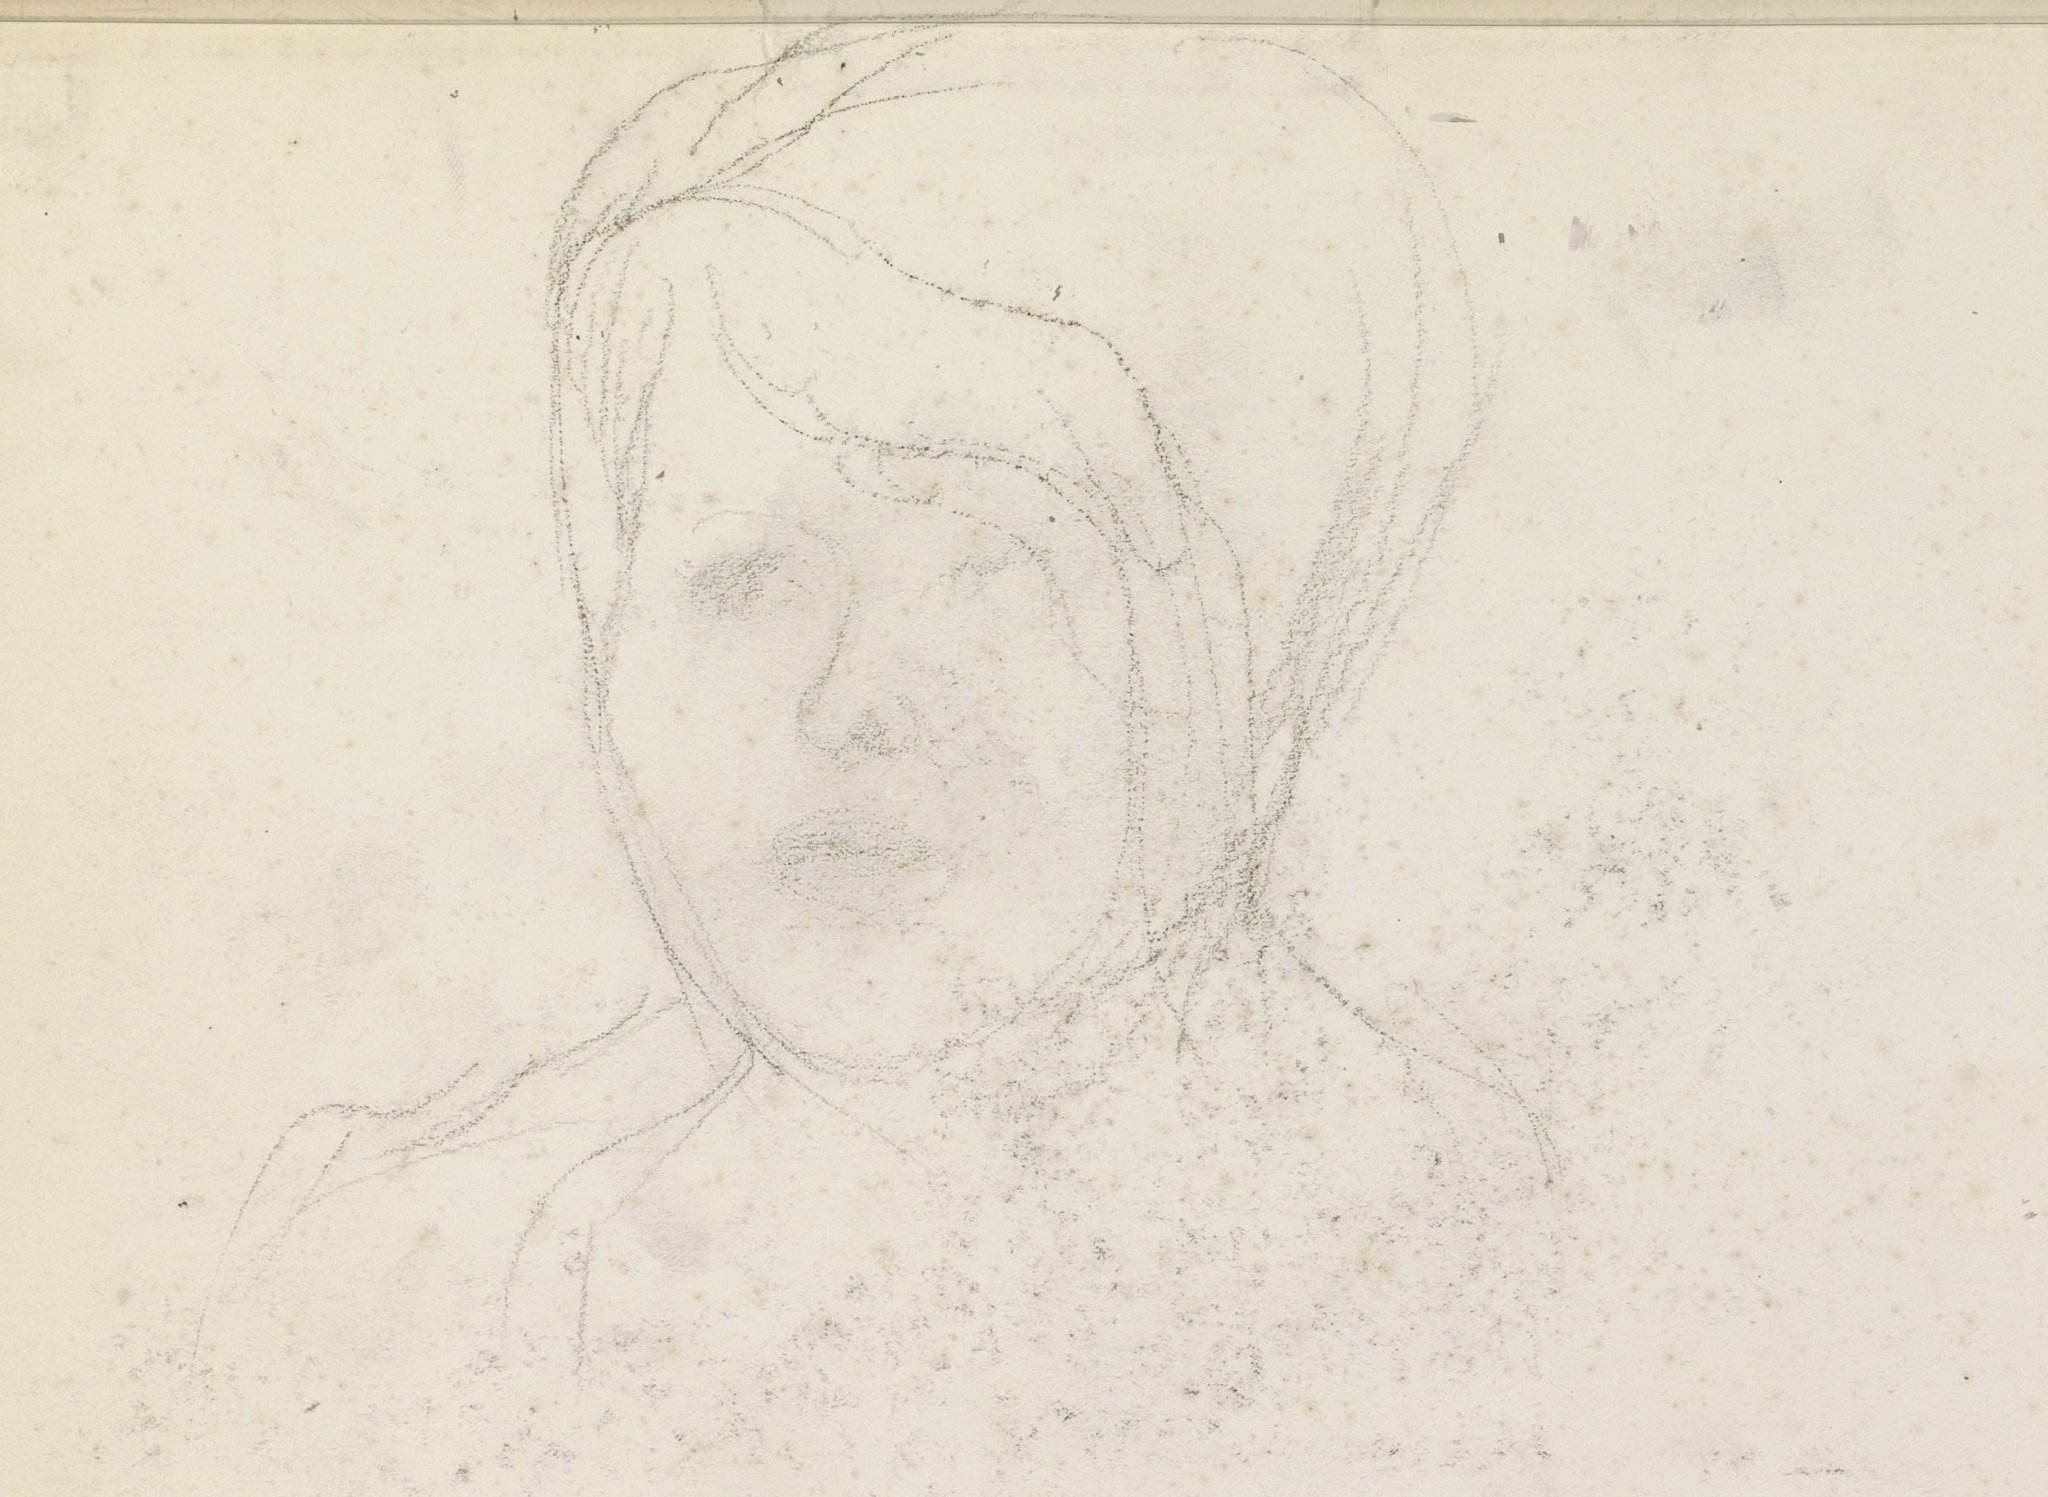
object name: endleaf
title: Kop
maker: cornelis vreedenburgh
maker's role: draughtsman, print maker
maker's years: 1880-1946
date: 1890-1946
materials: chalk, paper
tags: head (human)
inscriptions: collector's mark: Lugt 2228a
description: Voorste schutblad uit een schetsboek met 24 bladen.